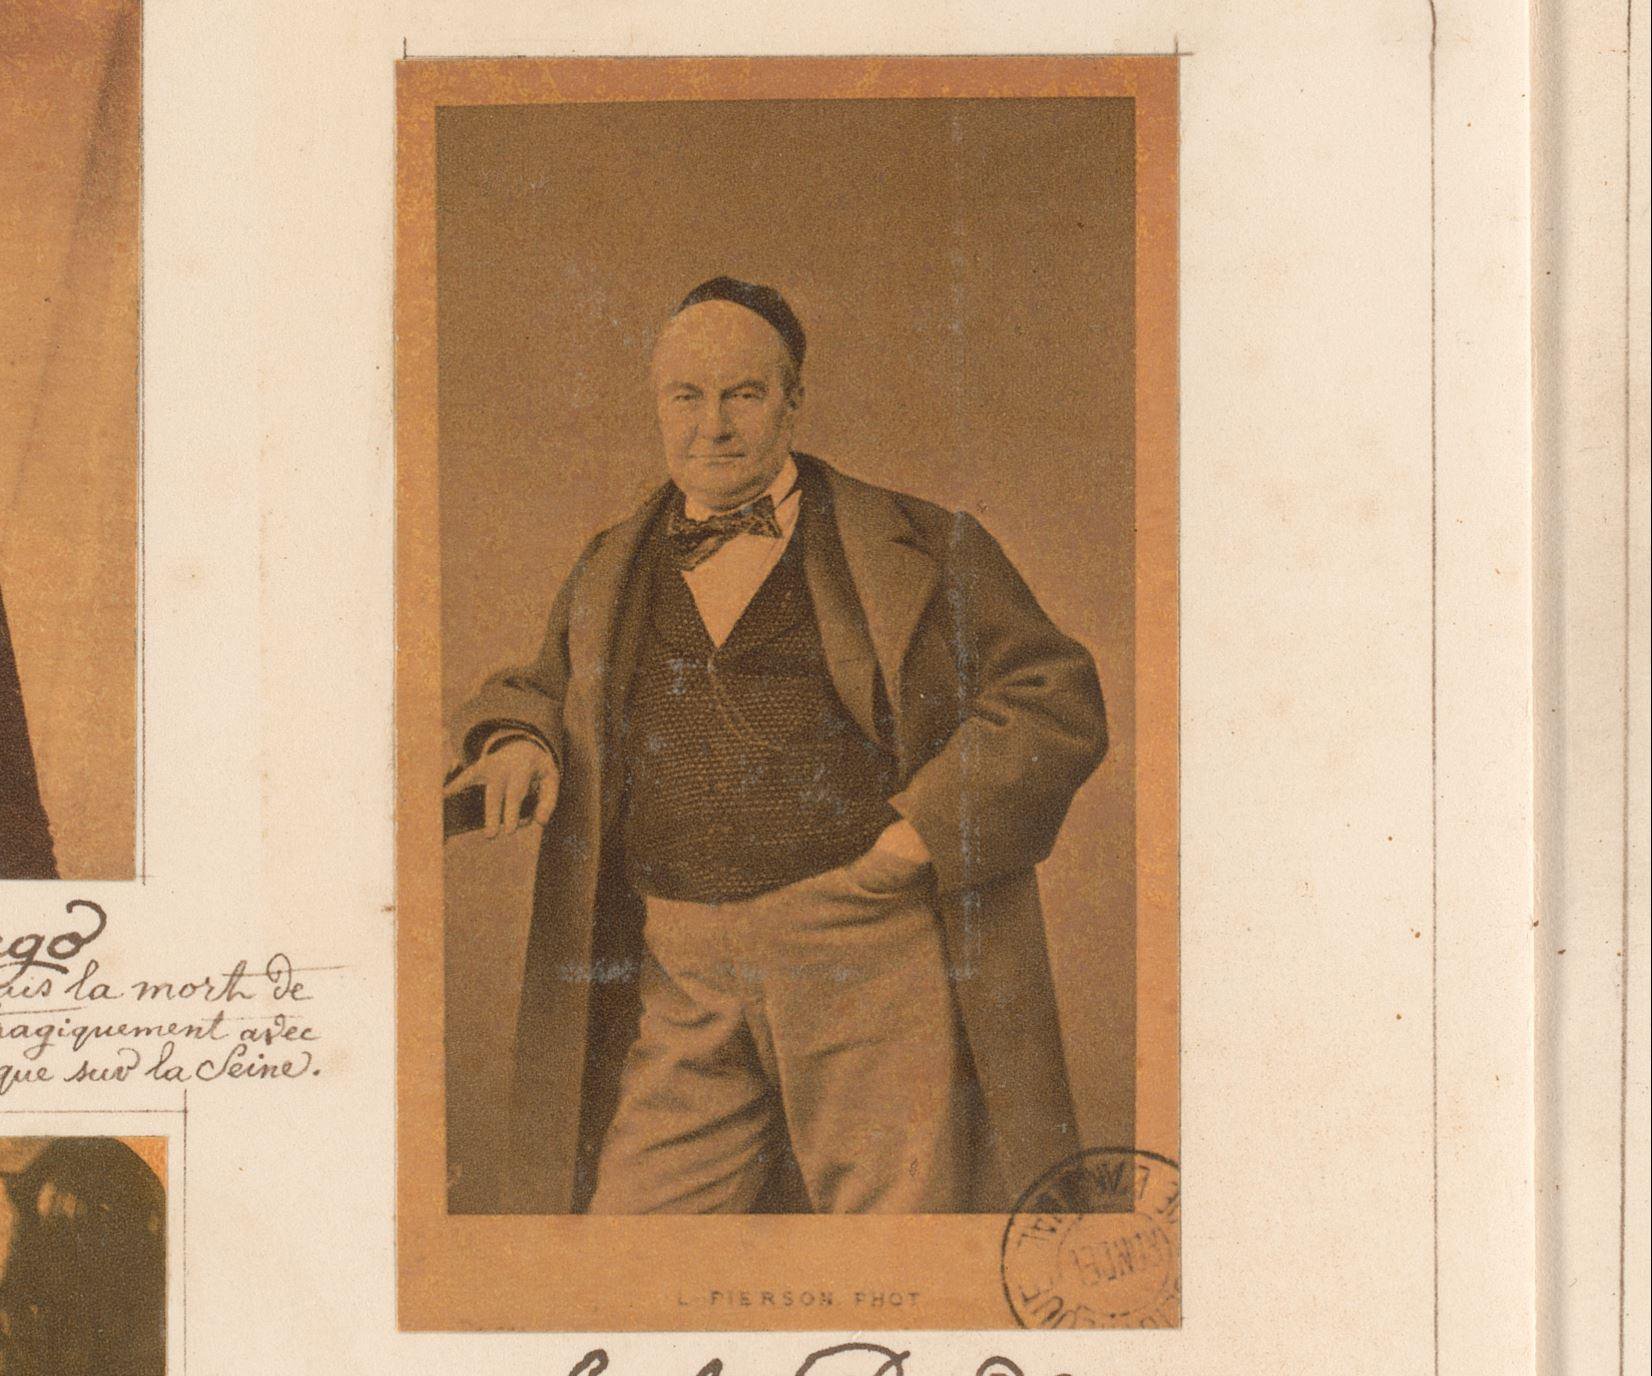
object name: photomechanical print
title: Juliette Drouet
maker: Anonymous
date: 1845-1853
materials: paper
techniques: rotogravure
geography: france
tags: portrait of actor, actress, france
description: Deze prent maakt deel uit van een album.